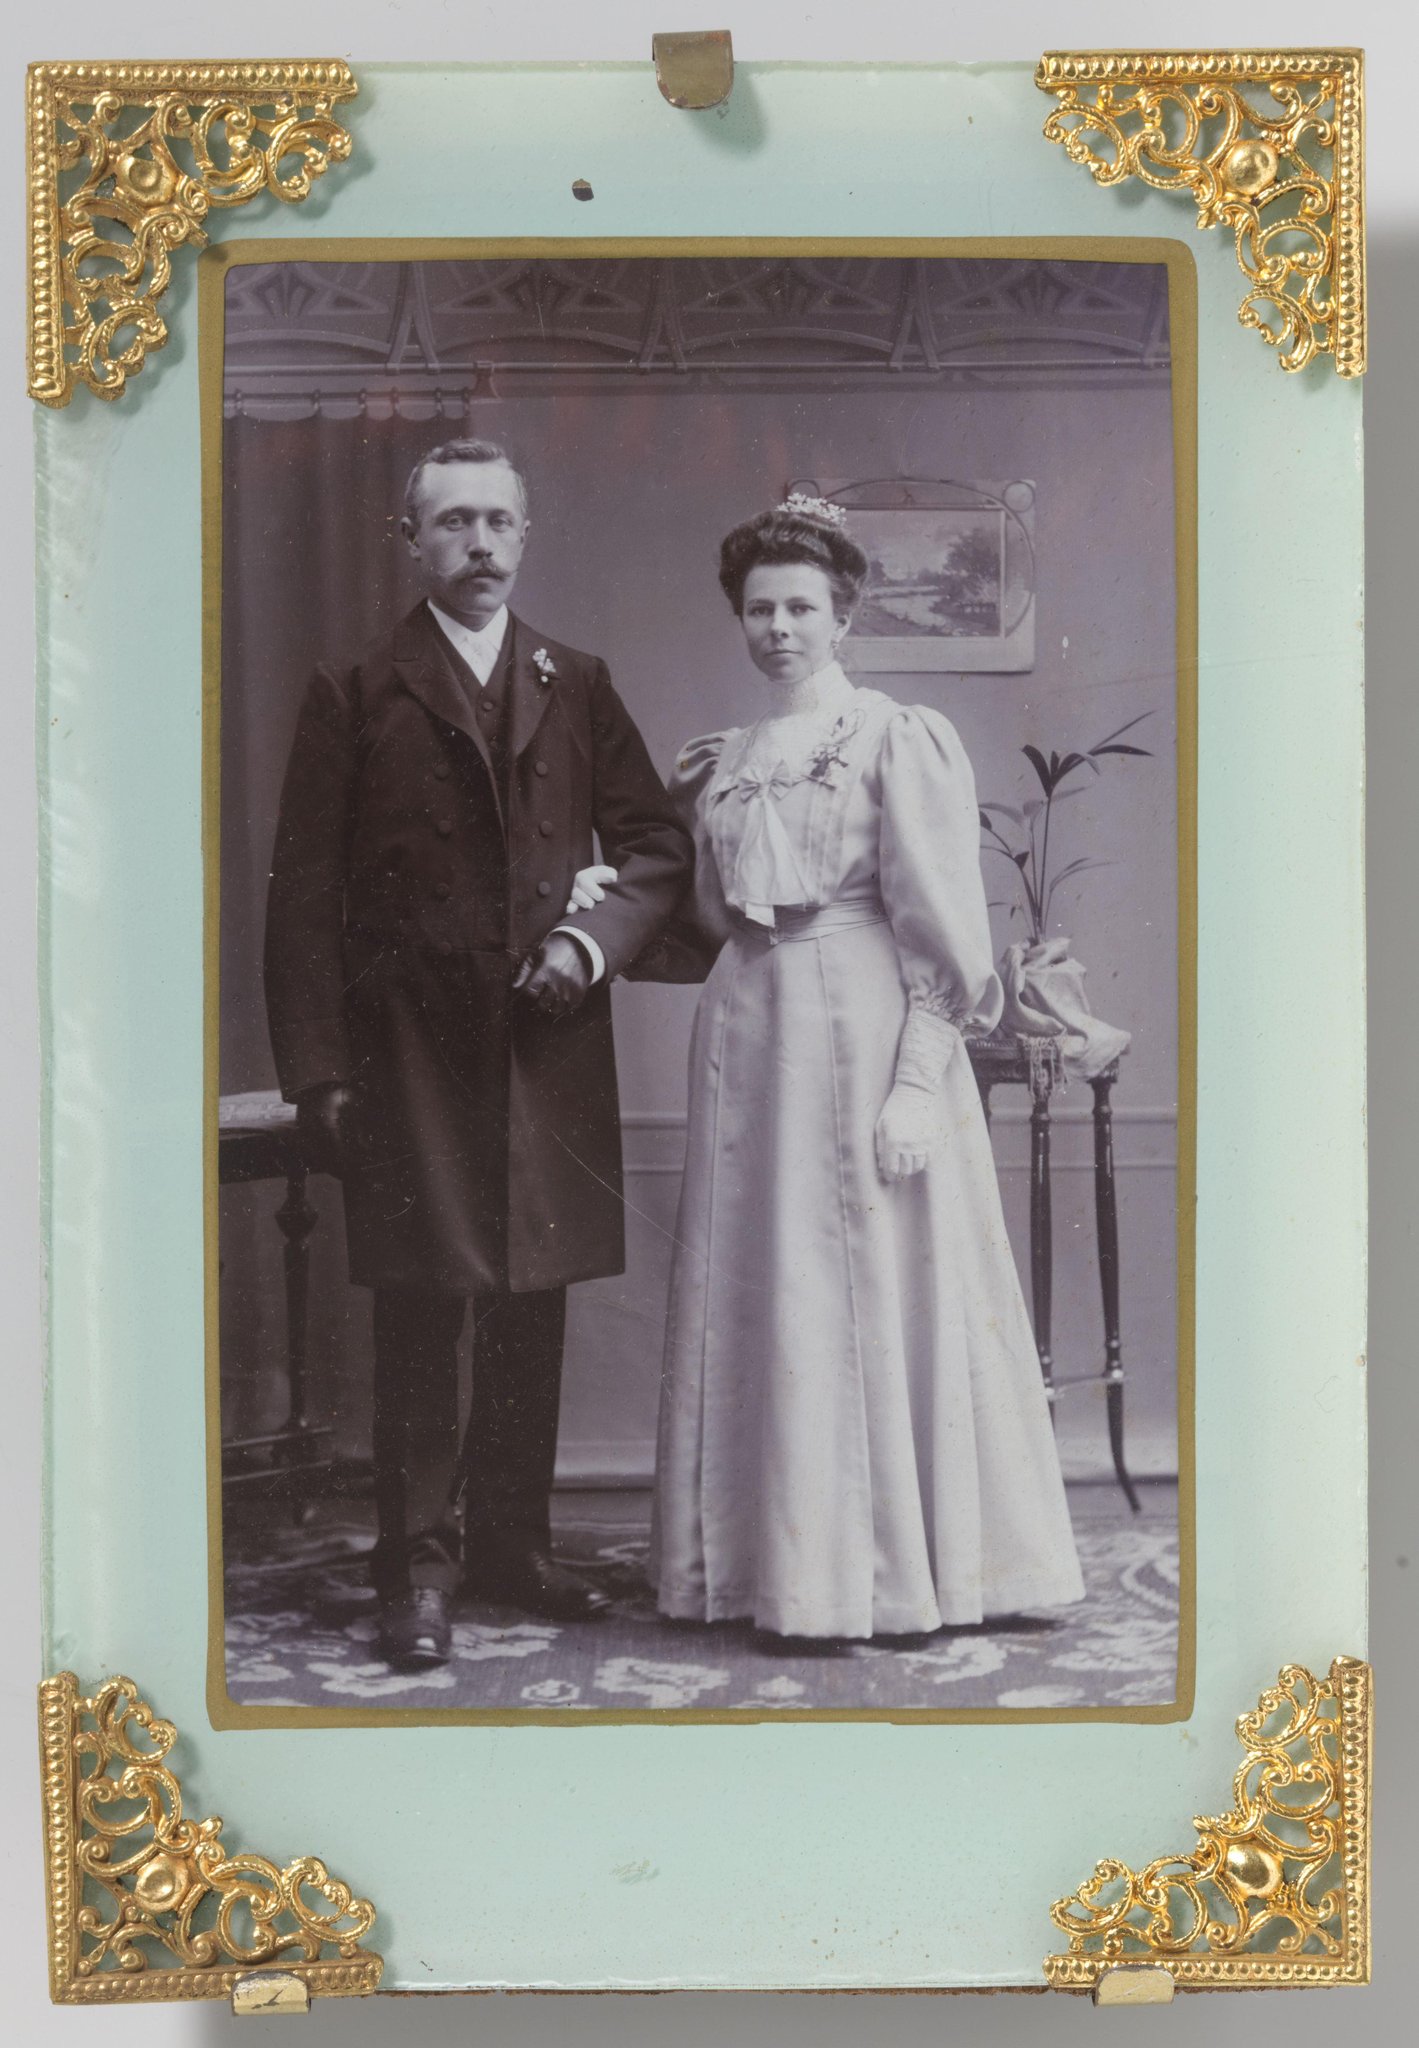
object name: photograph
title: Portret van een onbekend echtpaar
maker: Anonymous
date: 1880-1900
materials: paper, cardboard, glass, metal, wood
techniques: collodion silver print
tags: anonymous historical person portrayed, couple of lovers